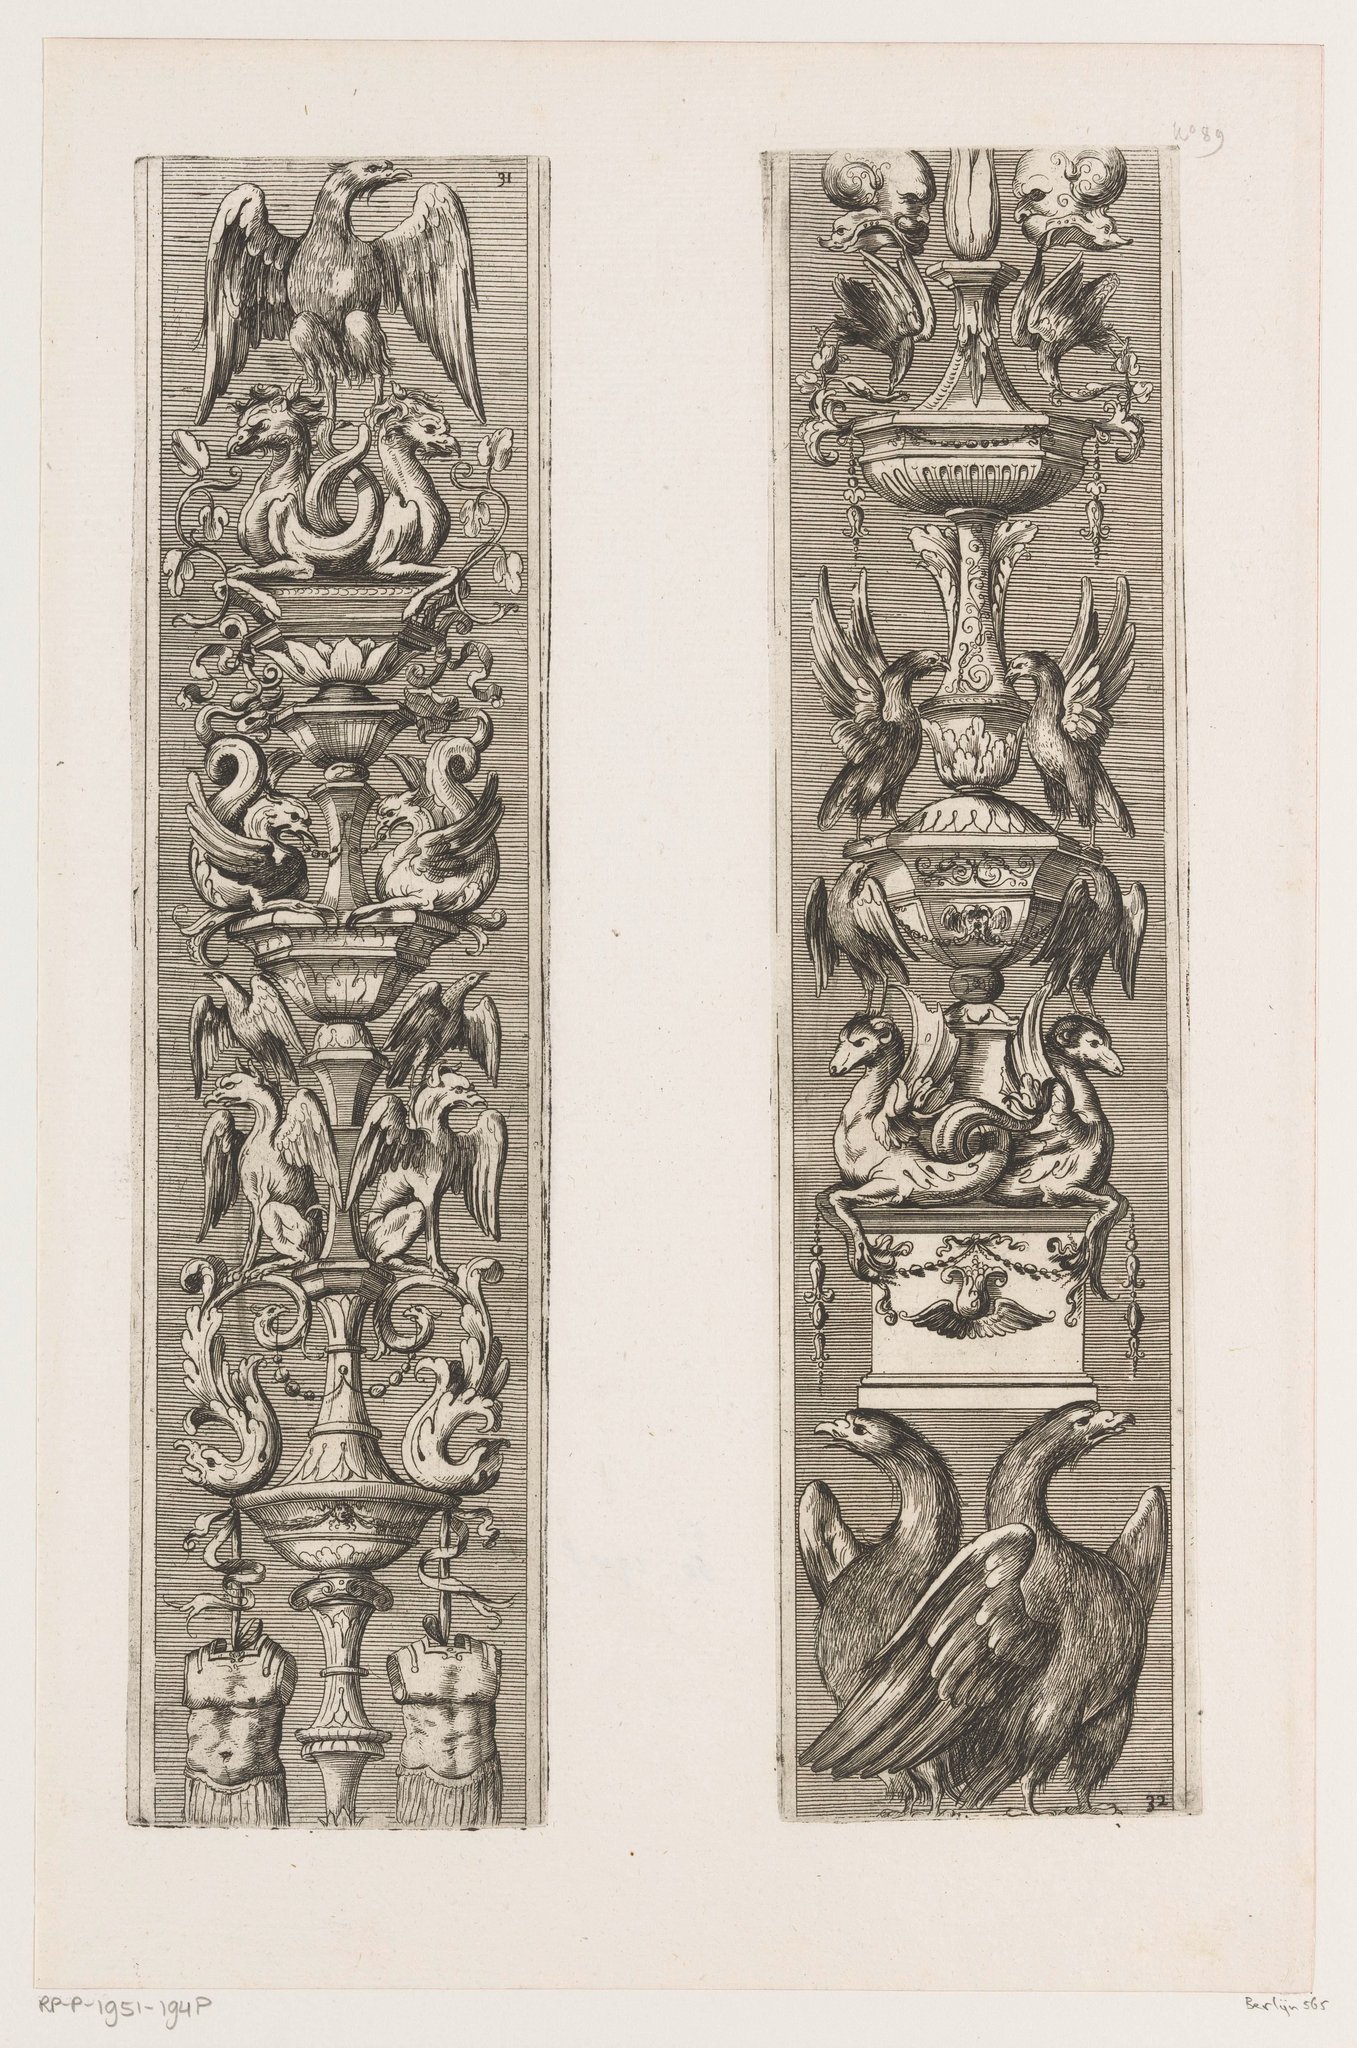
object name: print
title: Freggi dell' Architettura da Agostino Mitelli pittore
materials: paper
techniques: etching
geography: italy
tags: ornament ~ candelabrum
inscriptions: collector's mark: Lugt 2228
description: Deze prent maakt deel uit van een reeks van 48 prenten plus een titelprent. Mitelli maakte tekeningen van marmeren pilasterdecoraties van de poort van de S. Bartolomeo di Porta Ravegnana in Bologna. Deze prenten zijn vervolgens naar die tekeningen gemaakt.